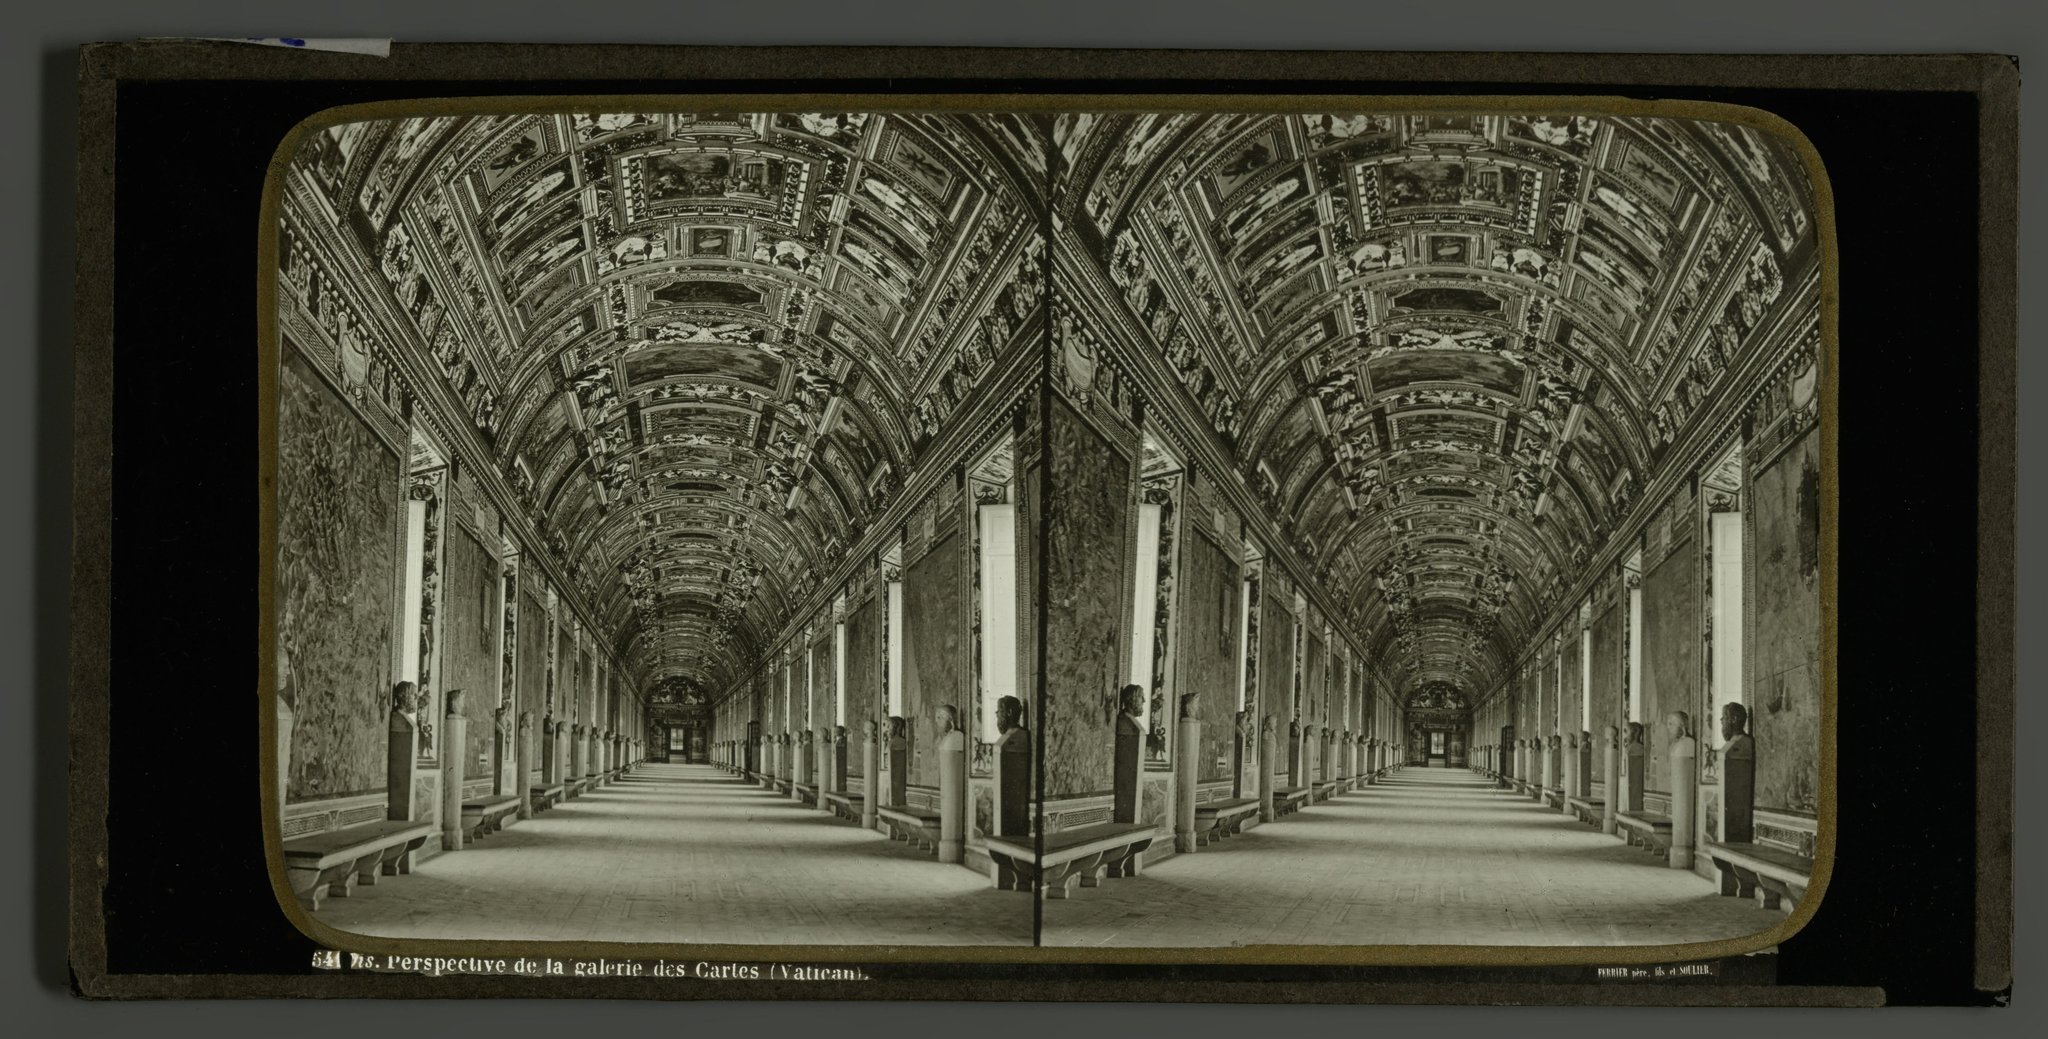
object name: stereoscopic photograph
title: Interieur van de Kaartengalerij in het Apostolisch Paleis te Vaticaanstad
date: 1860-1870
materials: glass, paper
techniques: slide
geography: vatican city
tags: maps, atlases, gallery (spacious corridor)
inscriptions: inscription: ‘541 bis Perspective de la galerie des Cartes (Vatican)’